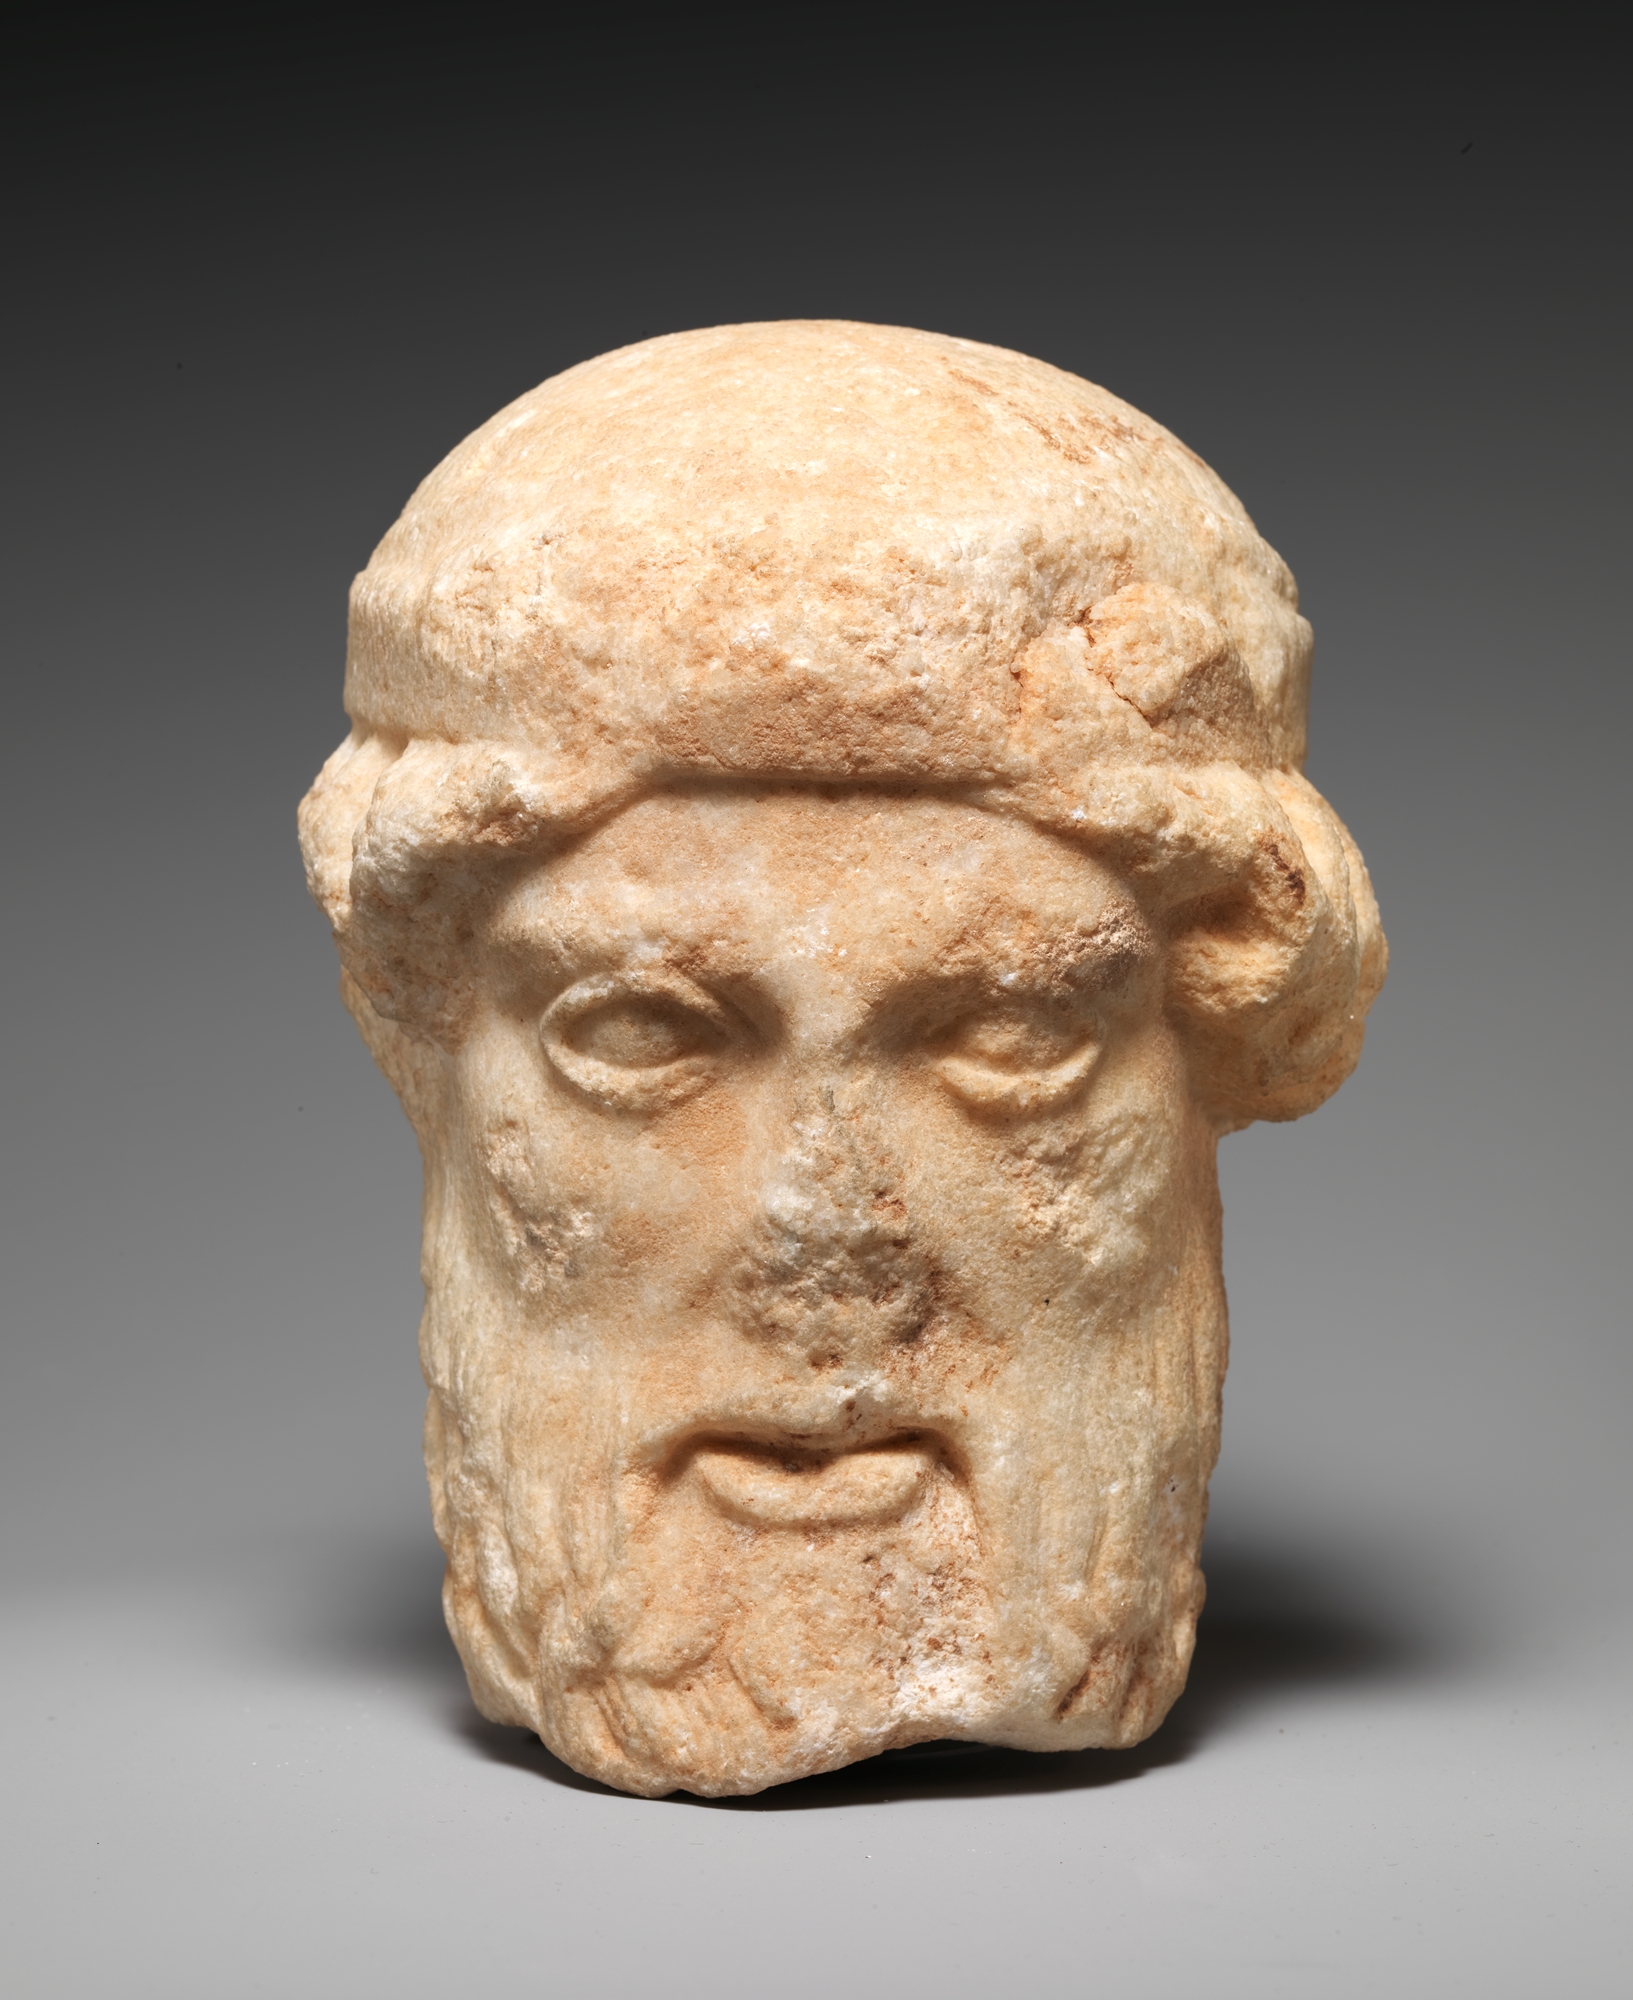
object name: head from a herm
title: Marble herm head of a bearded deity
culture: greek, attic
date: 450 BCE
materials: marble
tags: hermes